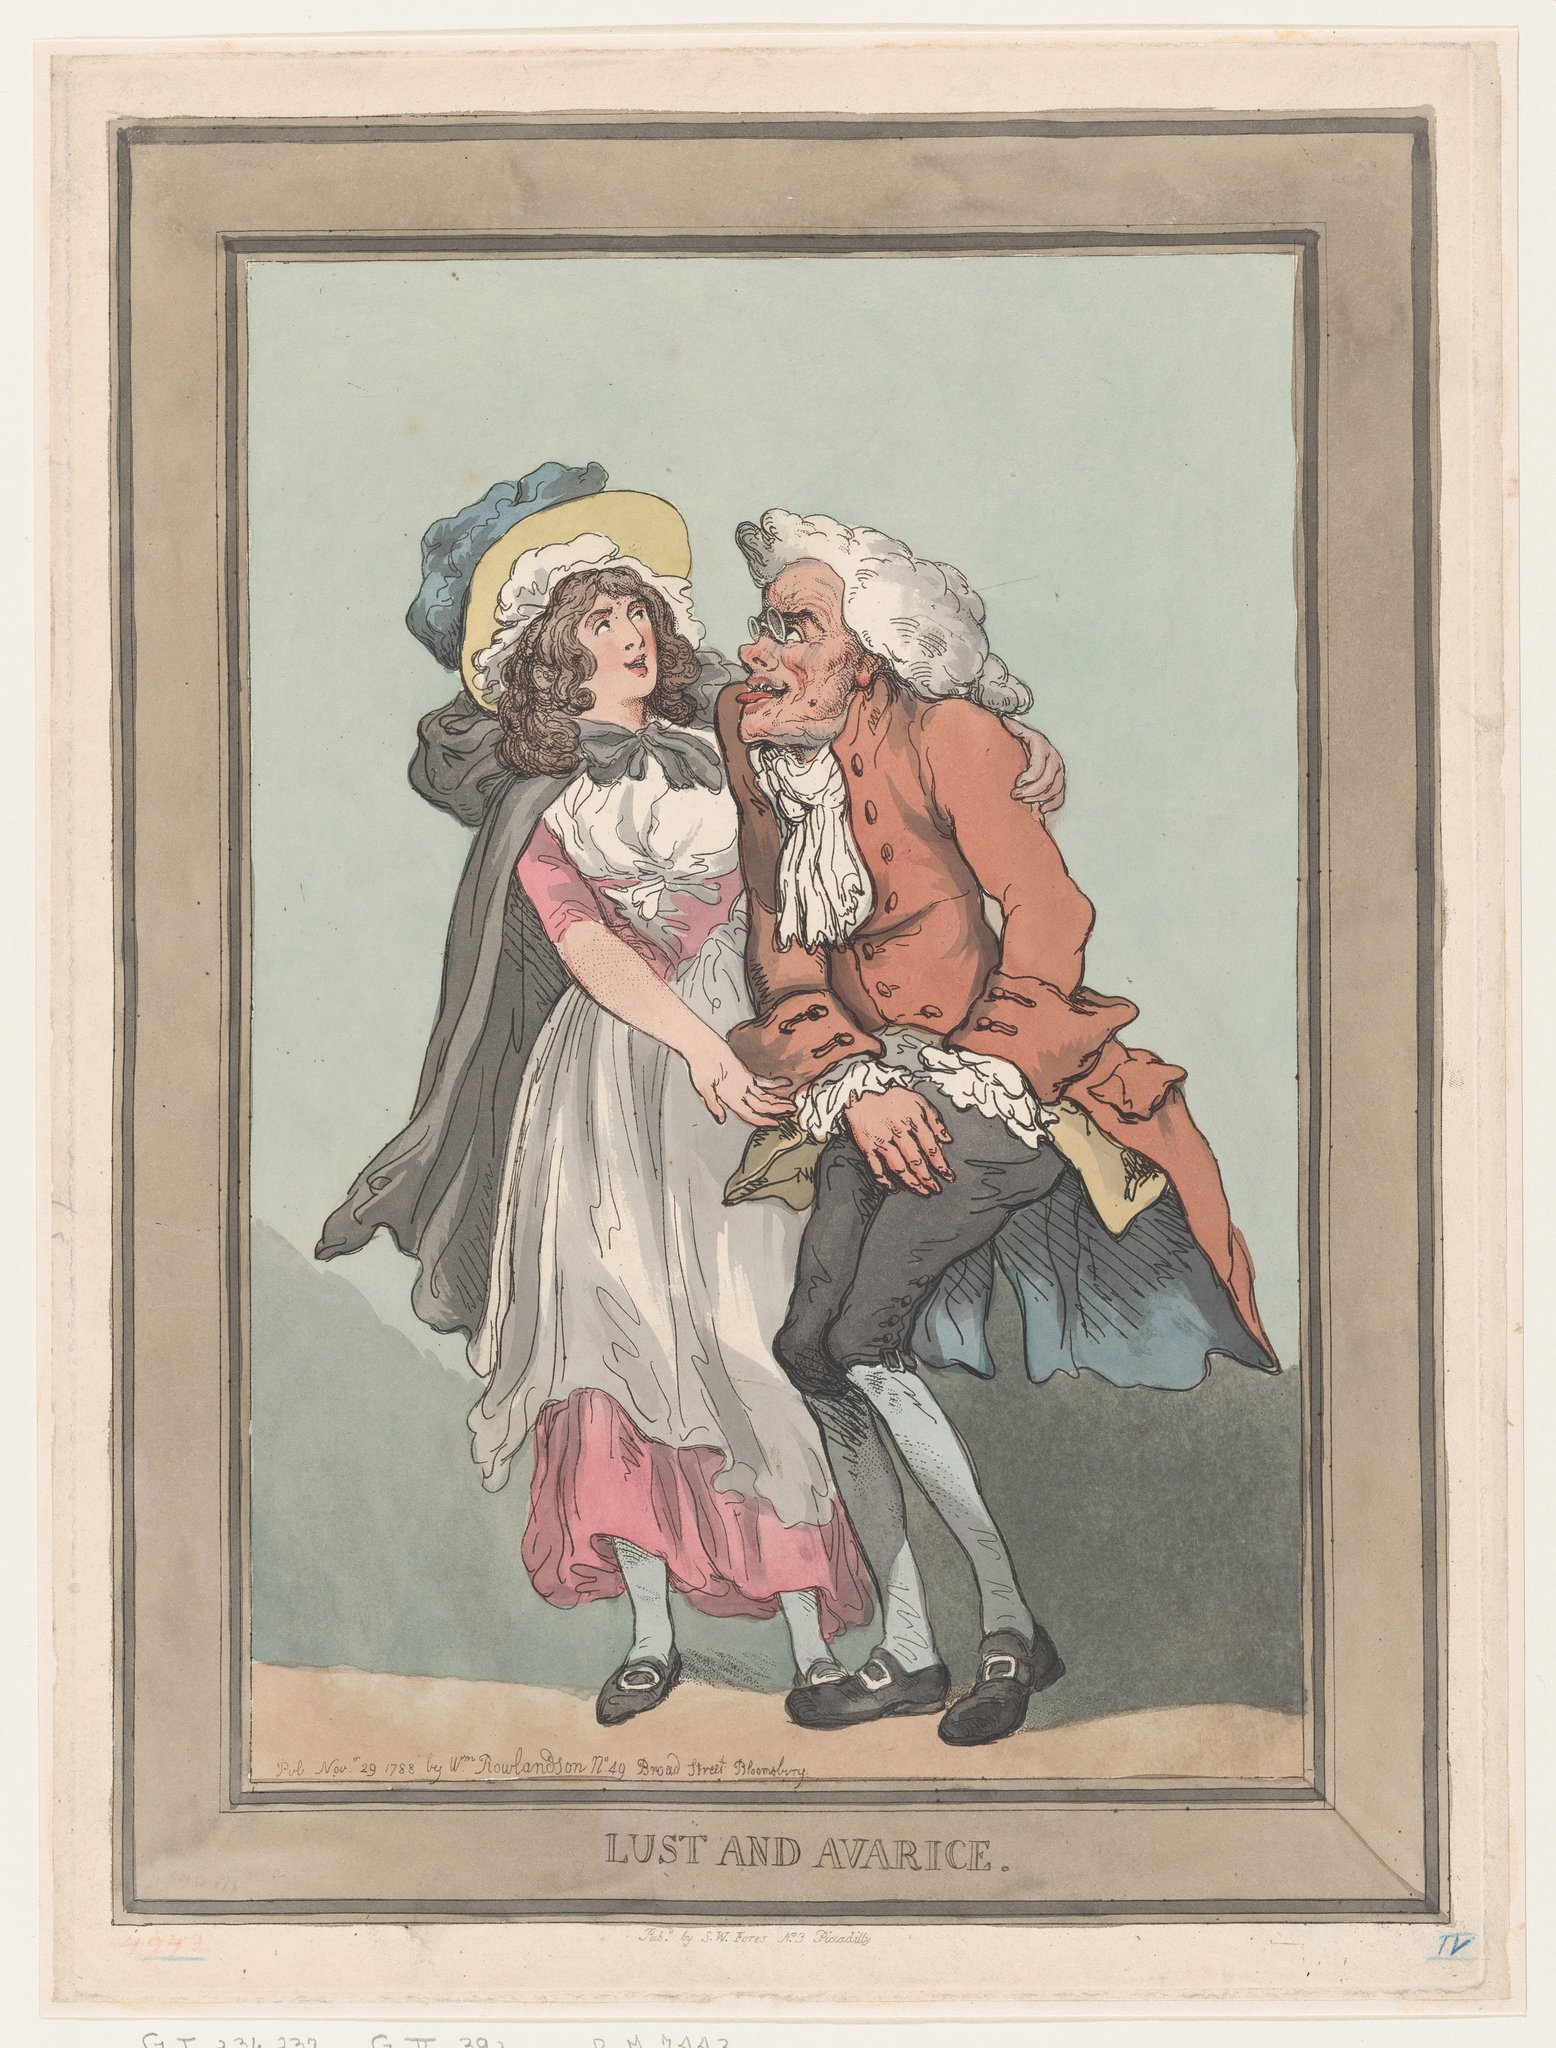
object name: print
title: Lust and Avarice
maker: thomas rowlandson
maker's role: artist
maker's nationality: british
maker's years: 1757-1827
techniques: etching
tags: men,women